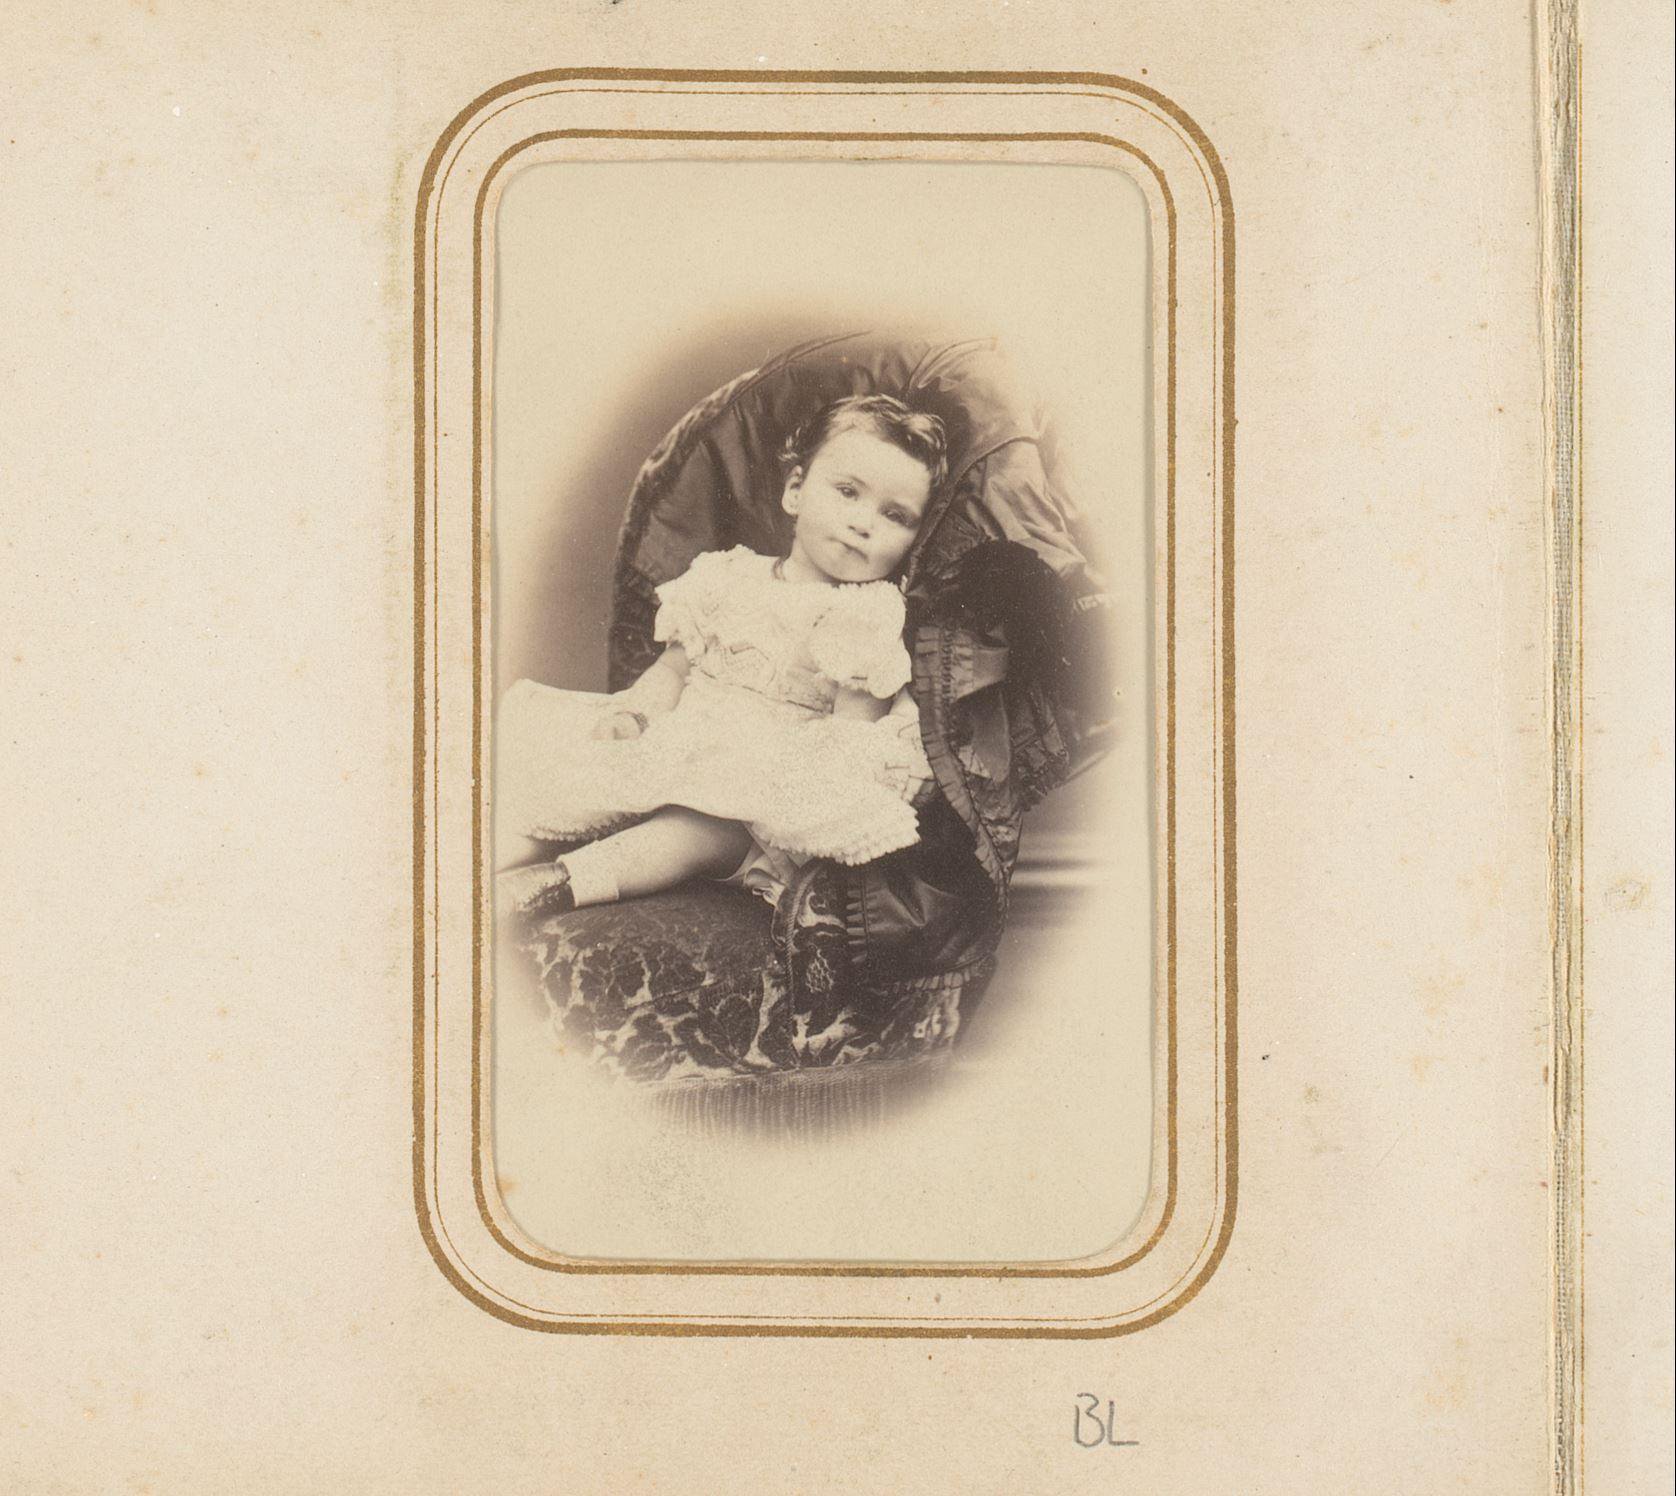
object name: photograph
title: Portret van meisje, zittend op een stoel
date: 1857-1864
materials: cardboard, photographic support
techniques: albumen print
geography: amsterdam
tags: girl (child between toddler and youth)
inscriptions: inscription: ‘Photogr. Atelier/ Wegner & Mottu/ Prinsengracht BB, 439/ Amsterdam’